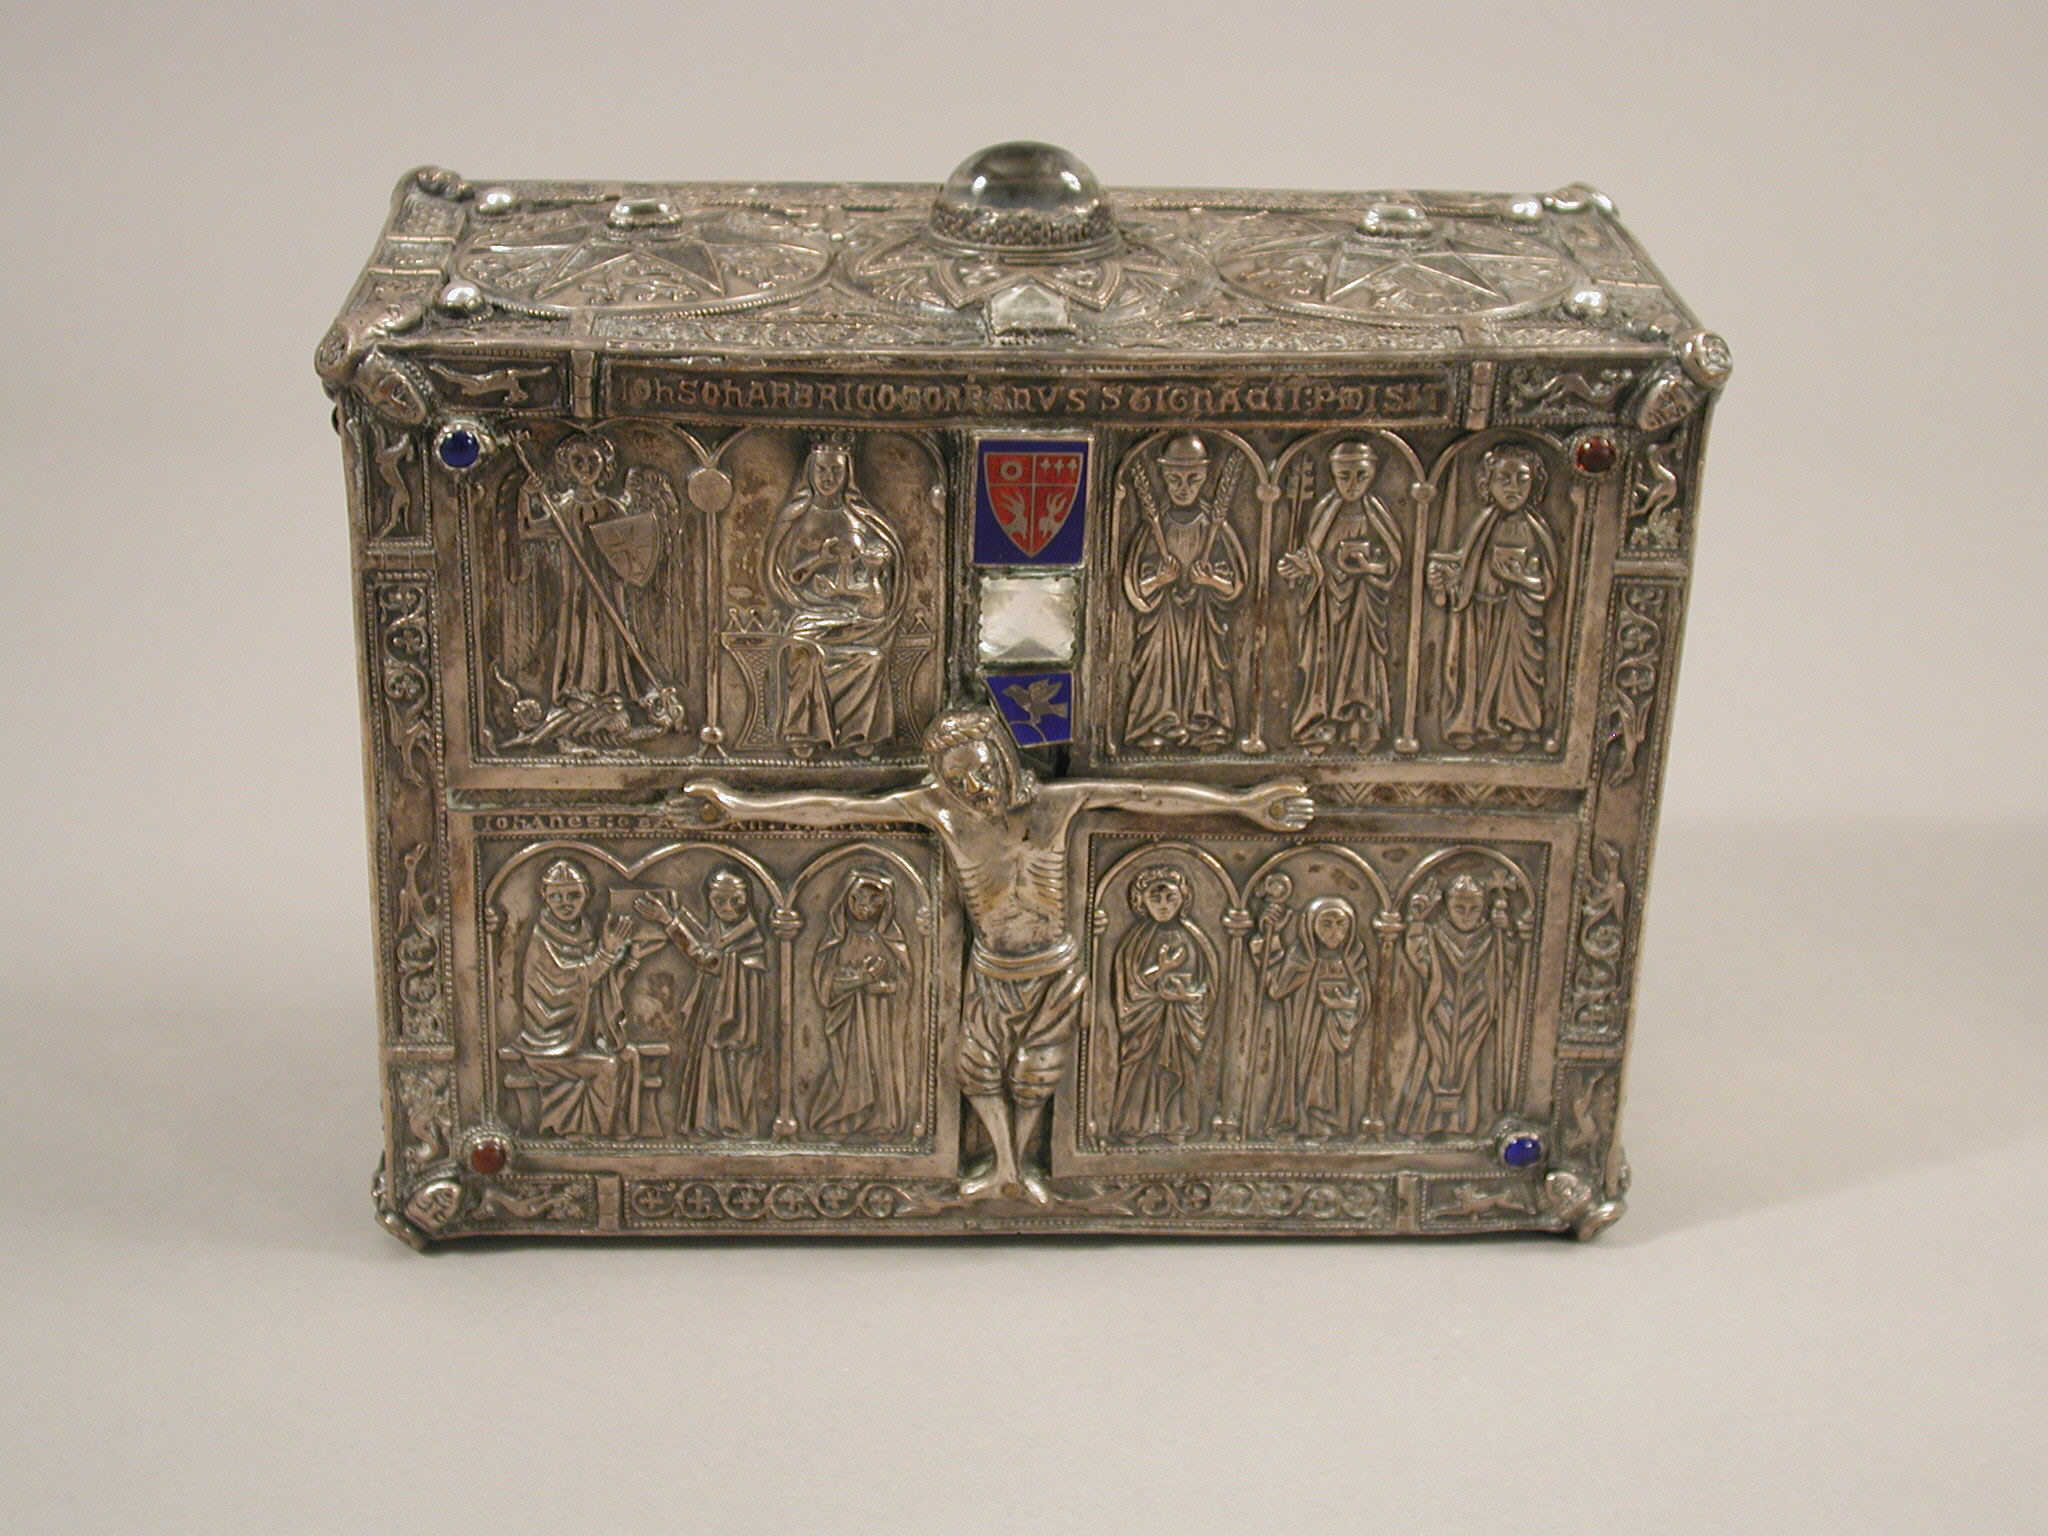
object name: shrine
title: Shrine of Saint Patrick's Gospels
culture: irish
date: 1901-1933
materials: bronze, enamel, gilt, stone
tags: christ,saints